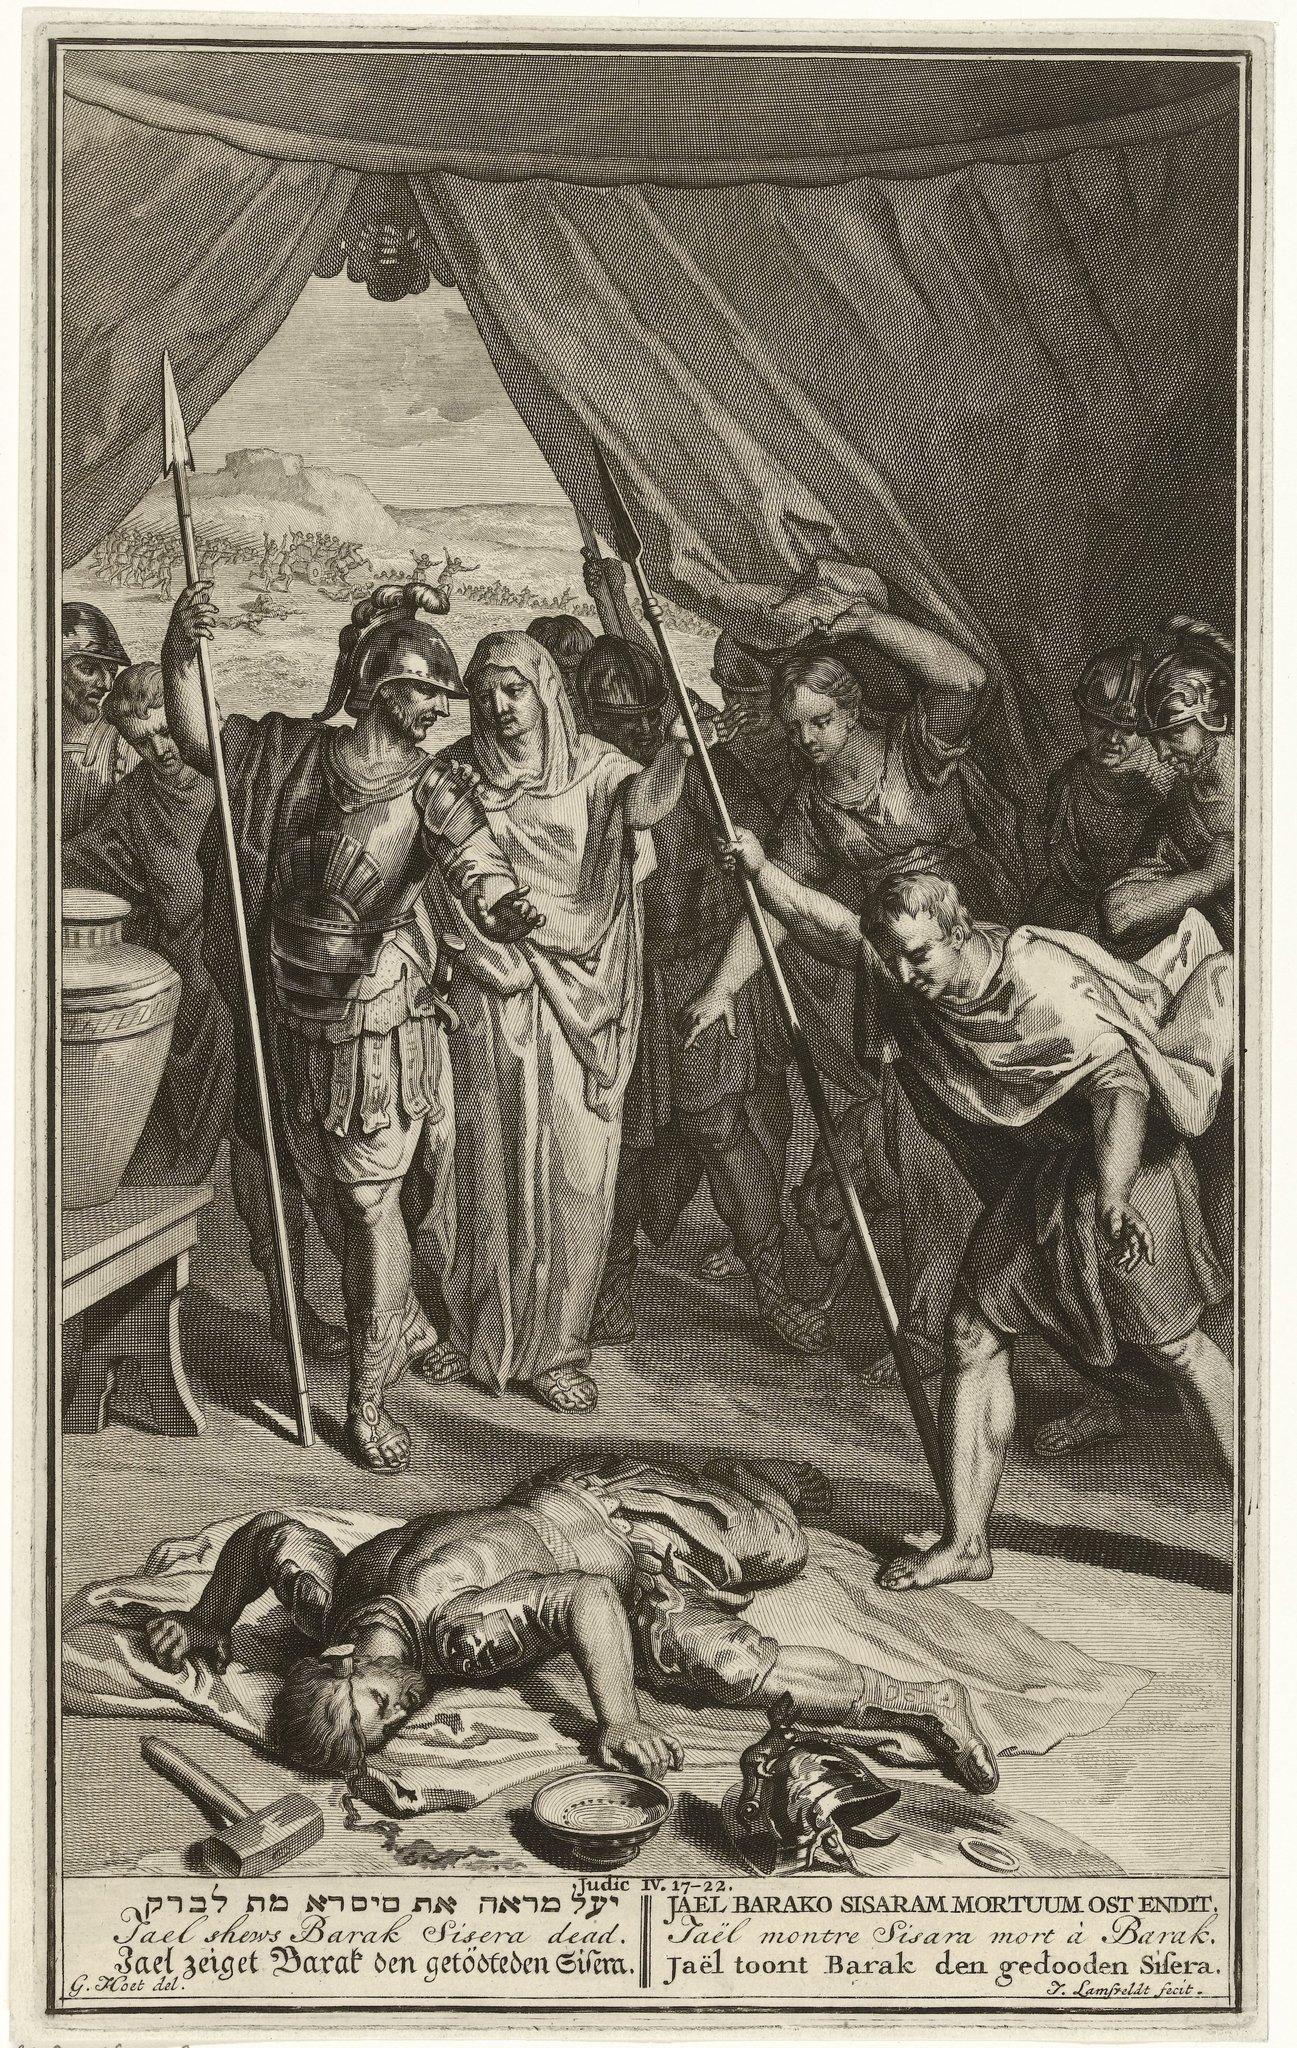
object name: print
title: Jaël toont Barak het dode lichaam van Sisera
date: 1684-1743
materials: paper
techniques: engraving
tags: barak comes to jael's tent; she shows him sisera's body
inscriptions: collector's mark: Lugt 2228, collector's mark: Lugt 2760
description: In een legertent ligt de gedode Sisera op de grond, een pin doorboort zijn hoofd. Links staat Jaël die Barak op het dode lichaam wijst. Bijbelse voorstelling uit Ri. 4:17-22 met in de marge de titel van de voorstelling in zes talen.